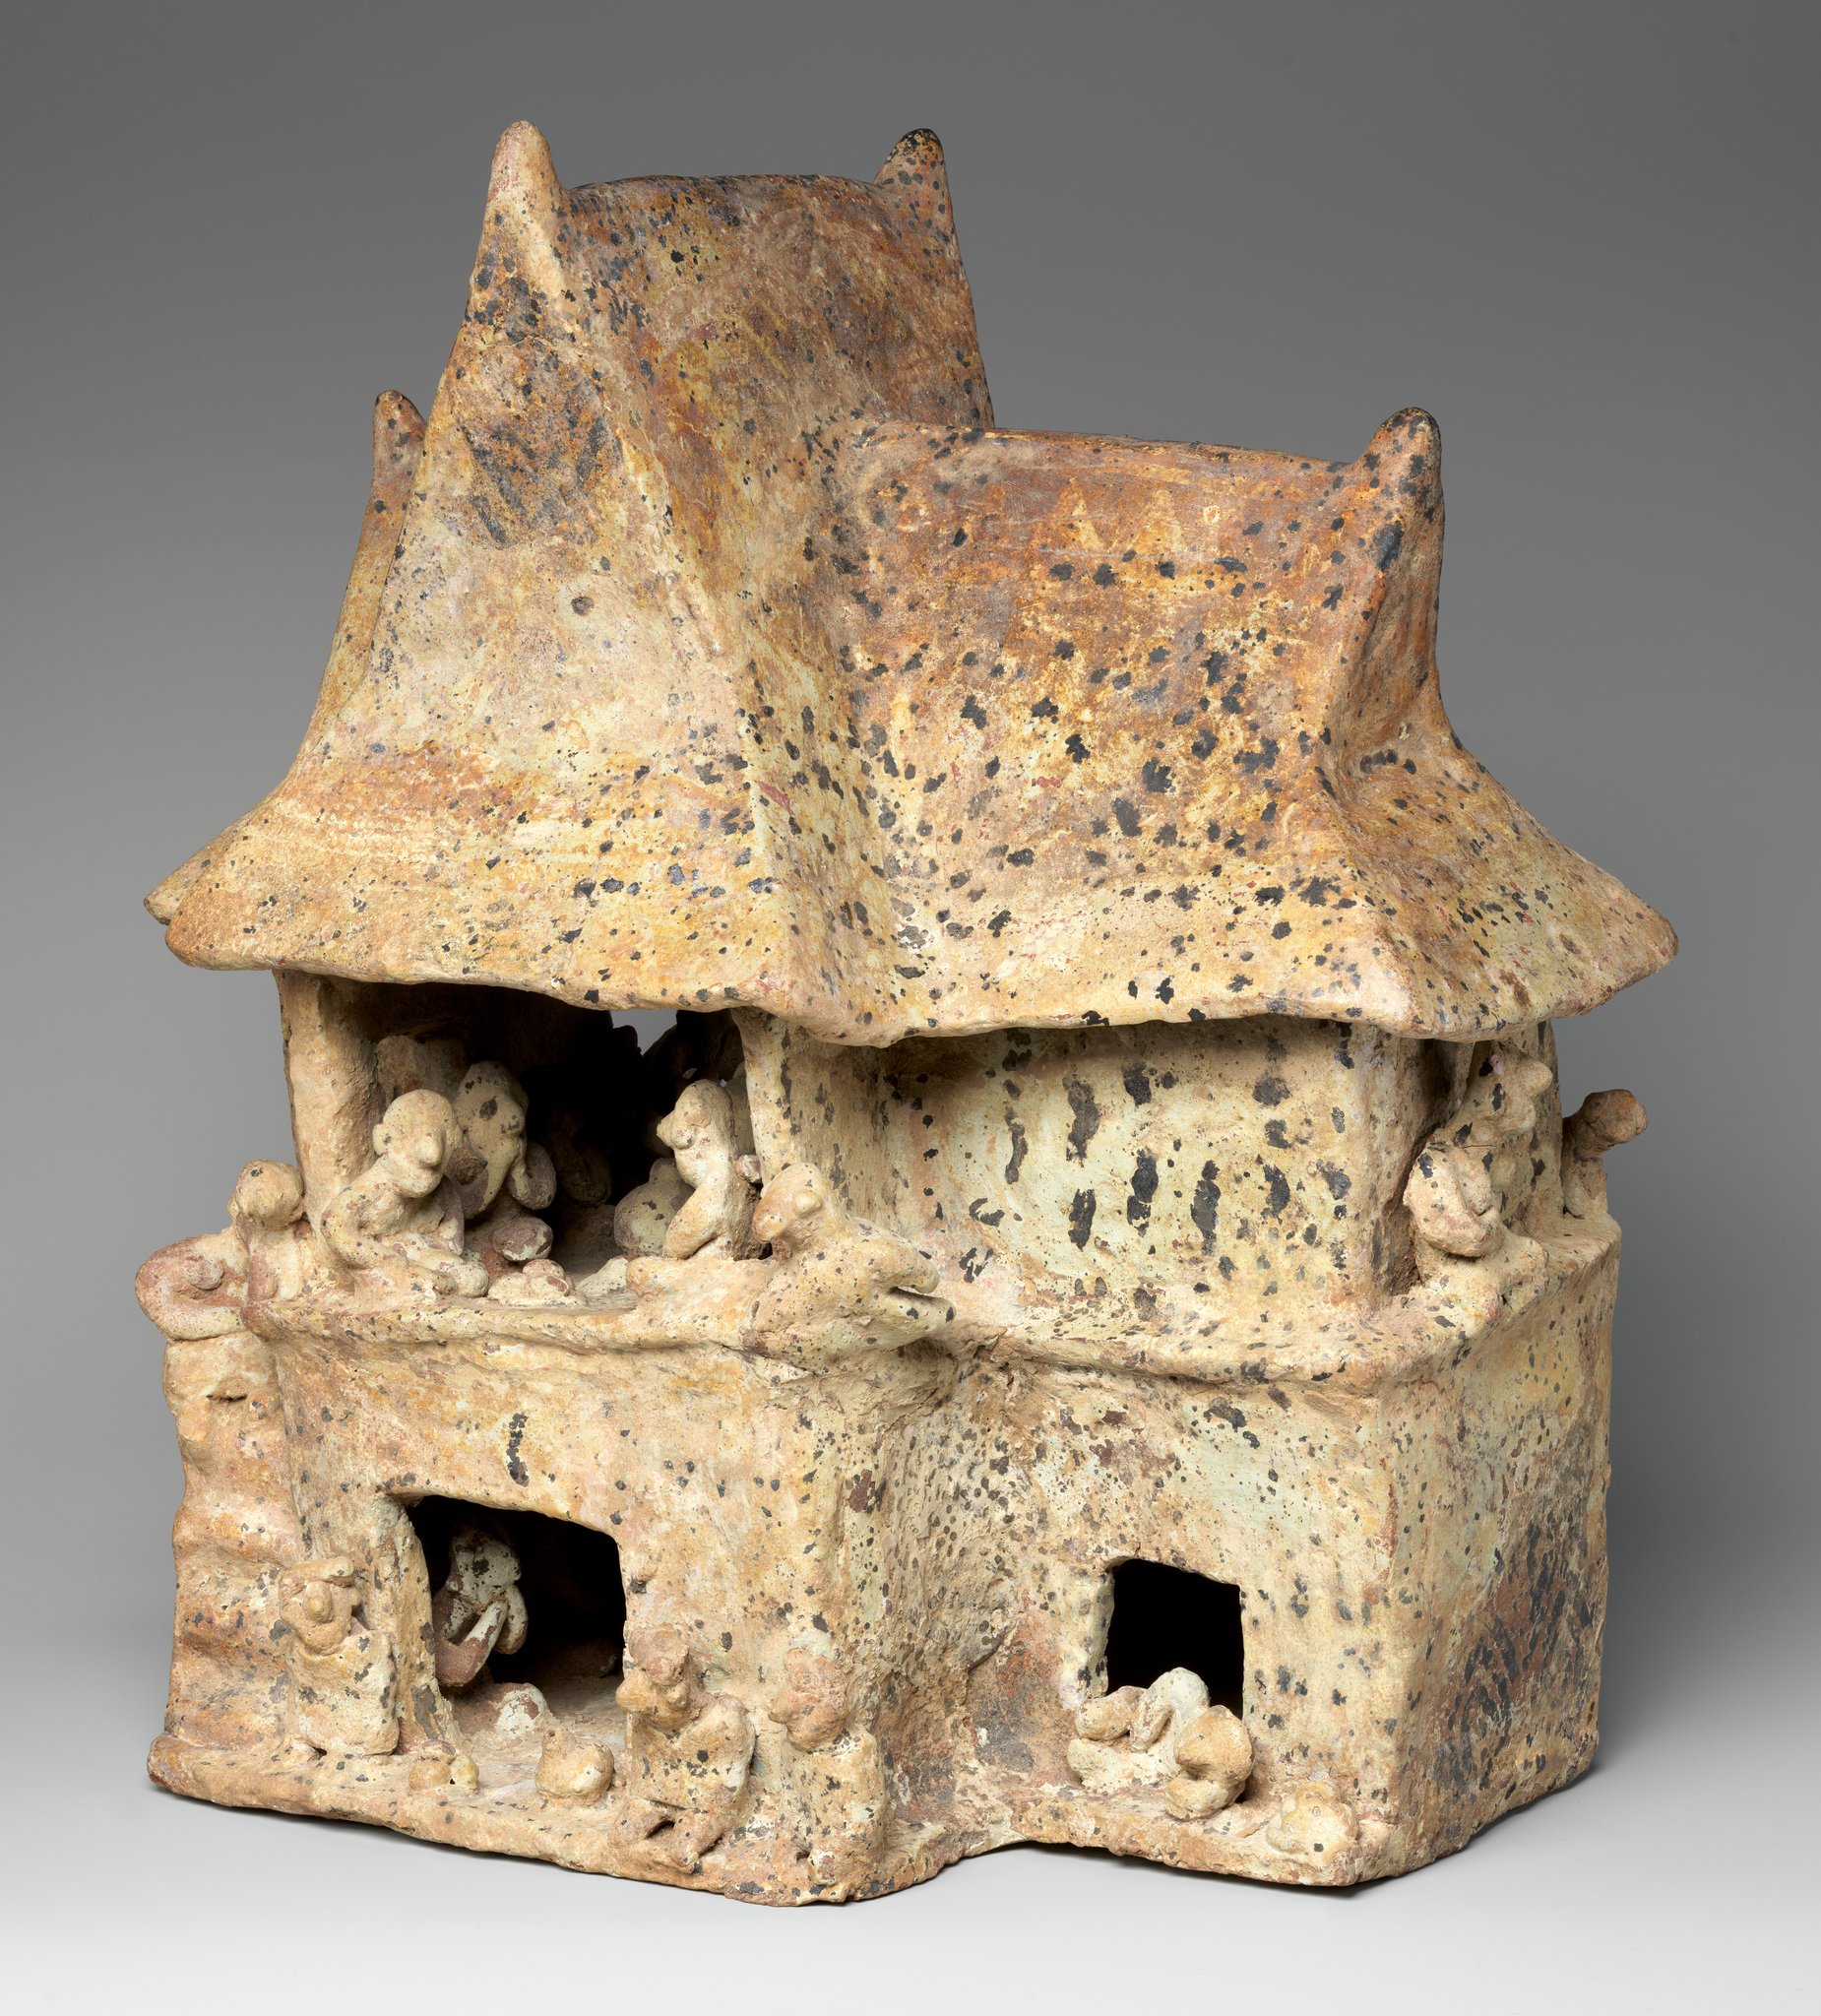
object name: house model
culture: nayarit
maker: nayarit artist(s)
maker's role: artist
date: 200 BCE-300 CE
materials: ceramic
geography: mexico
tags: houses